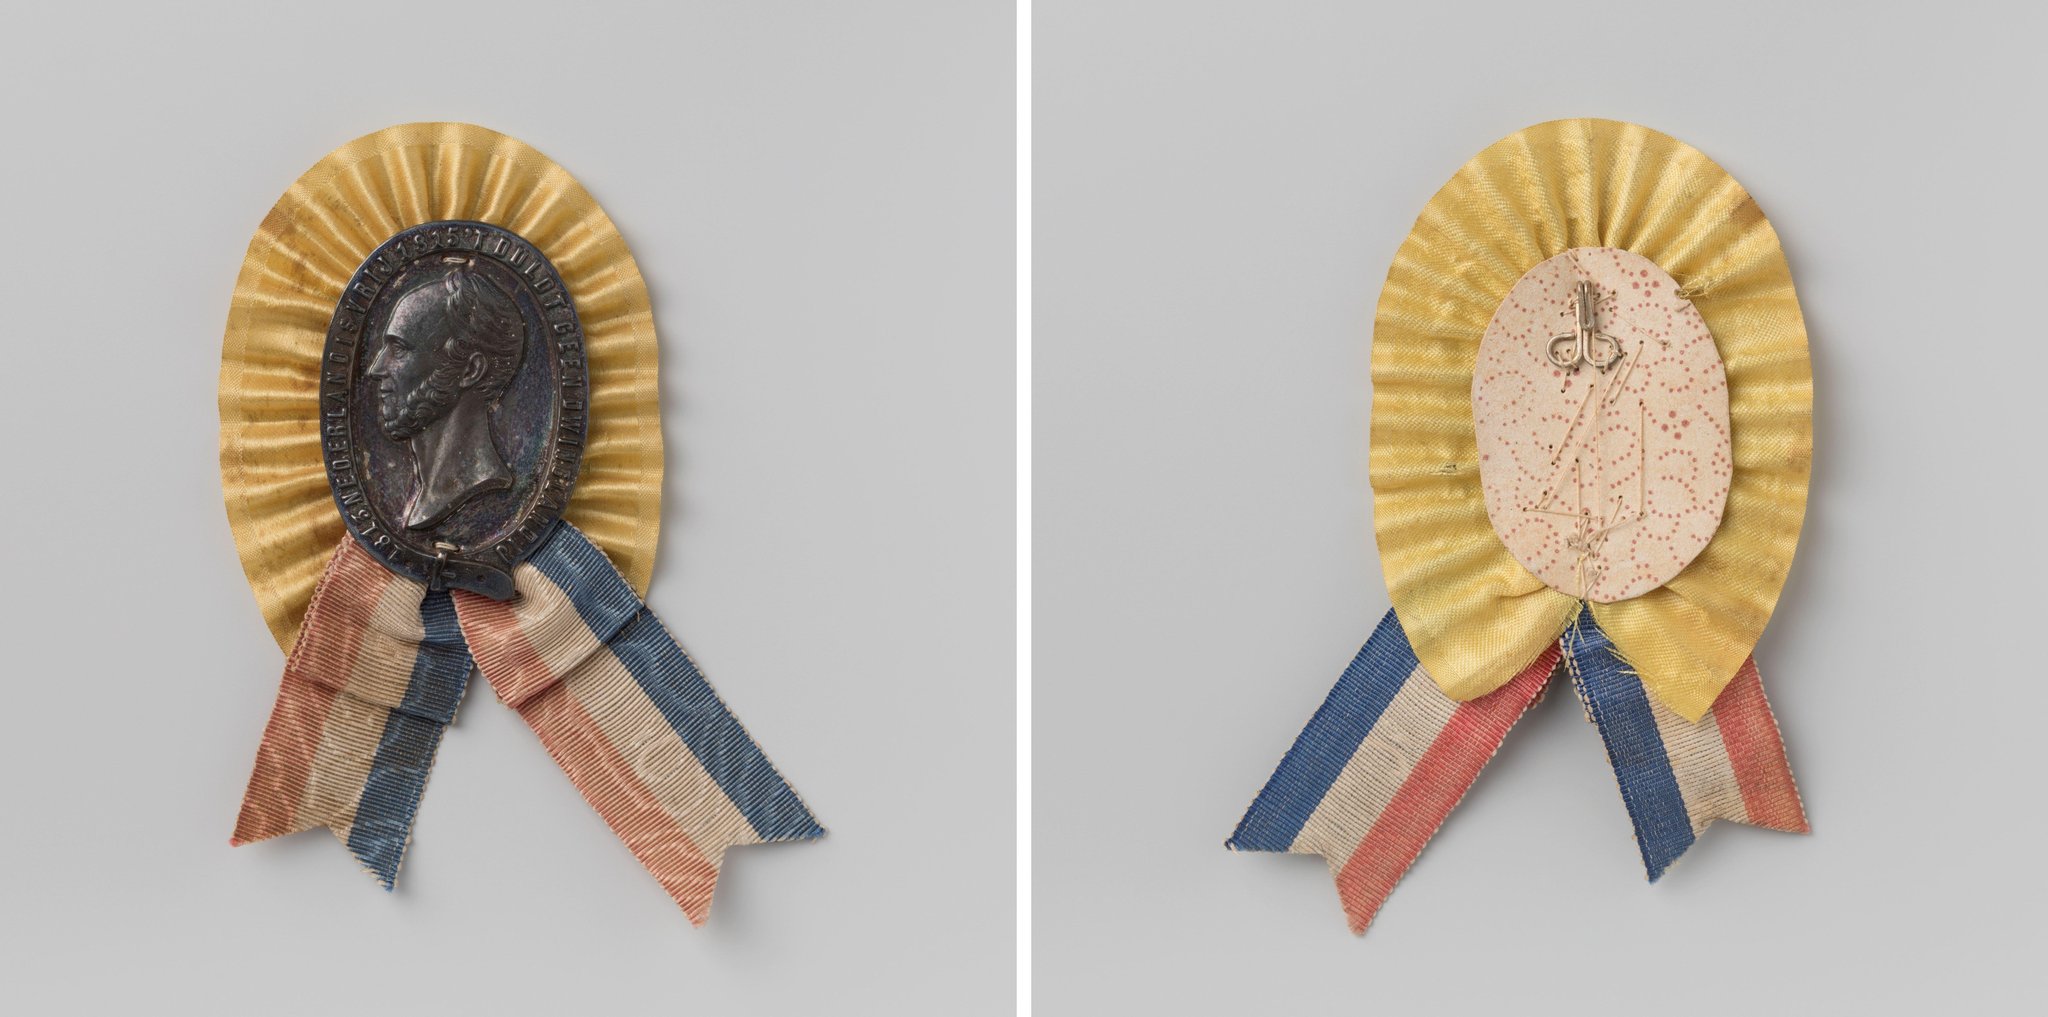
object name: insignia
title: Vijftigjarige herdenking van de slag bij Waterloo, ter ere van Willem II, koning der Nederlanden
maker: david van der kellen (1804-1879)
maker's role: die cutter, draughtsman, print maker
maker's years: 1804-1879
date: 1815-1865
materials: paper, silver, textile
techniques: striking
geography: utrecht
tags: the hague, william ii of the netherlands, waterloo